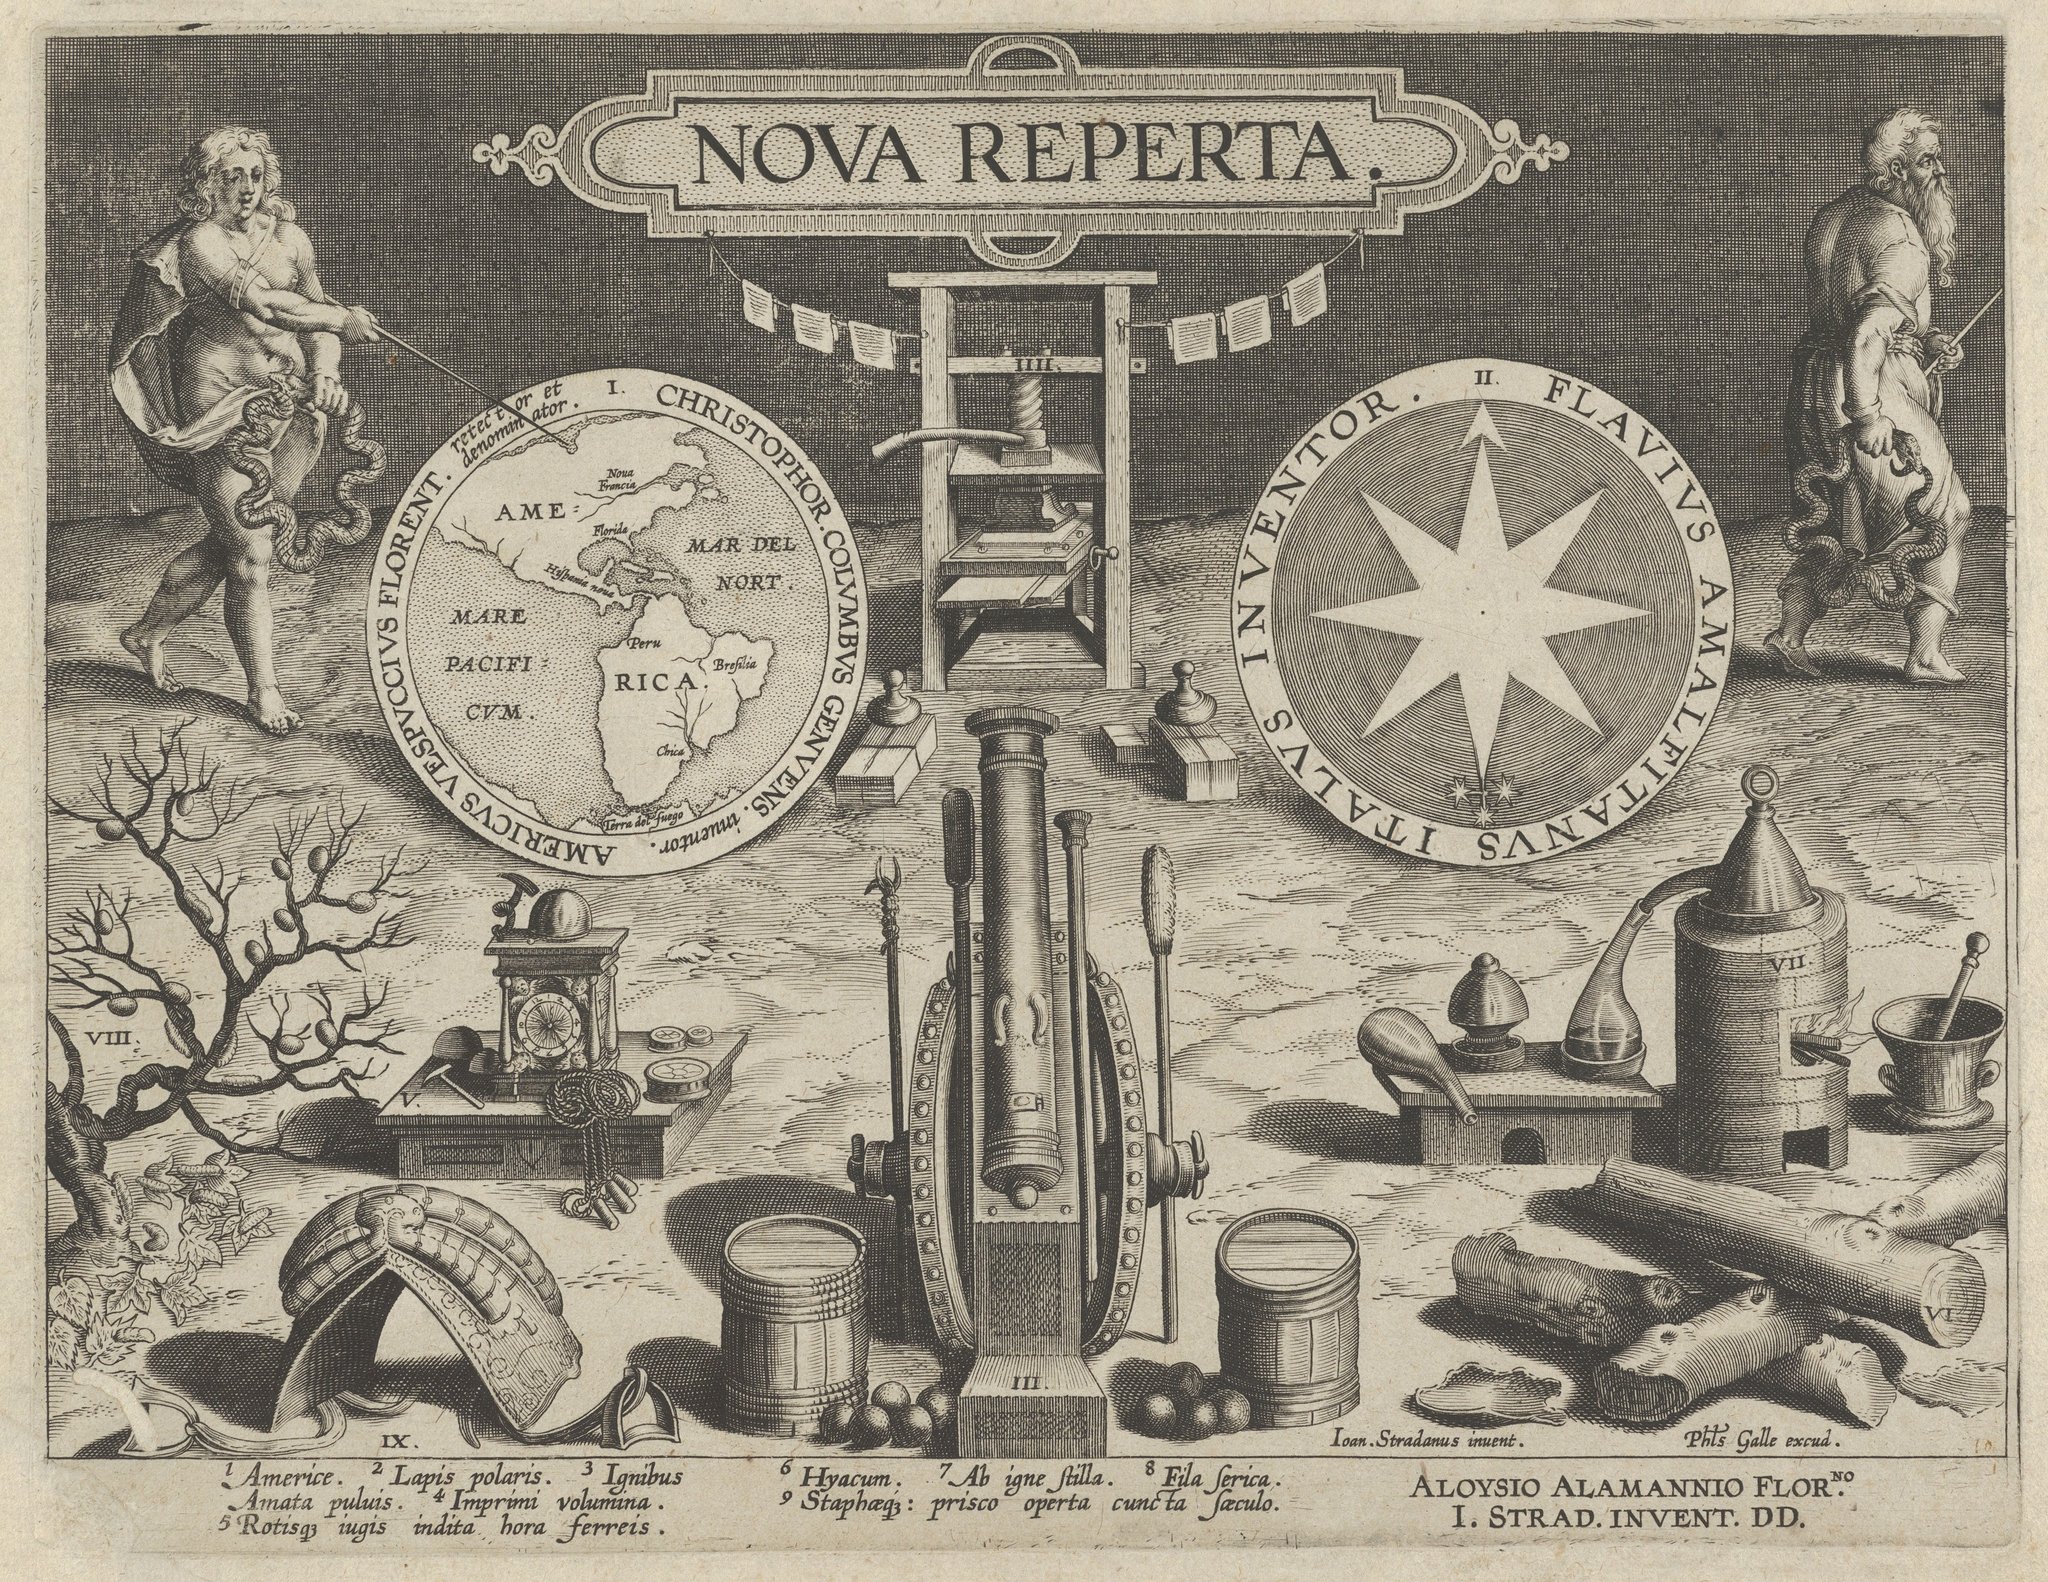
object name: print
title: New Inventions of Modern Times [Nova Reperta], Title Plate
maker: jan collaert i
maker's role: artist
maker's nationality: netherlandish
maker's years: 1530-1581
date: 1600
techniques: engraving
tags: cannons,women,maps,printing press